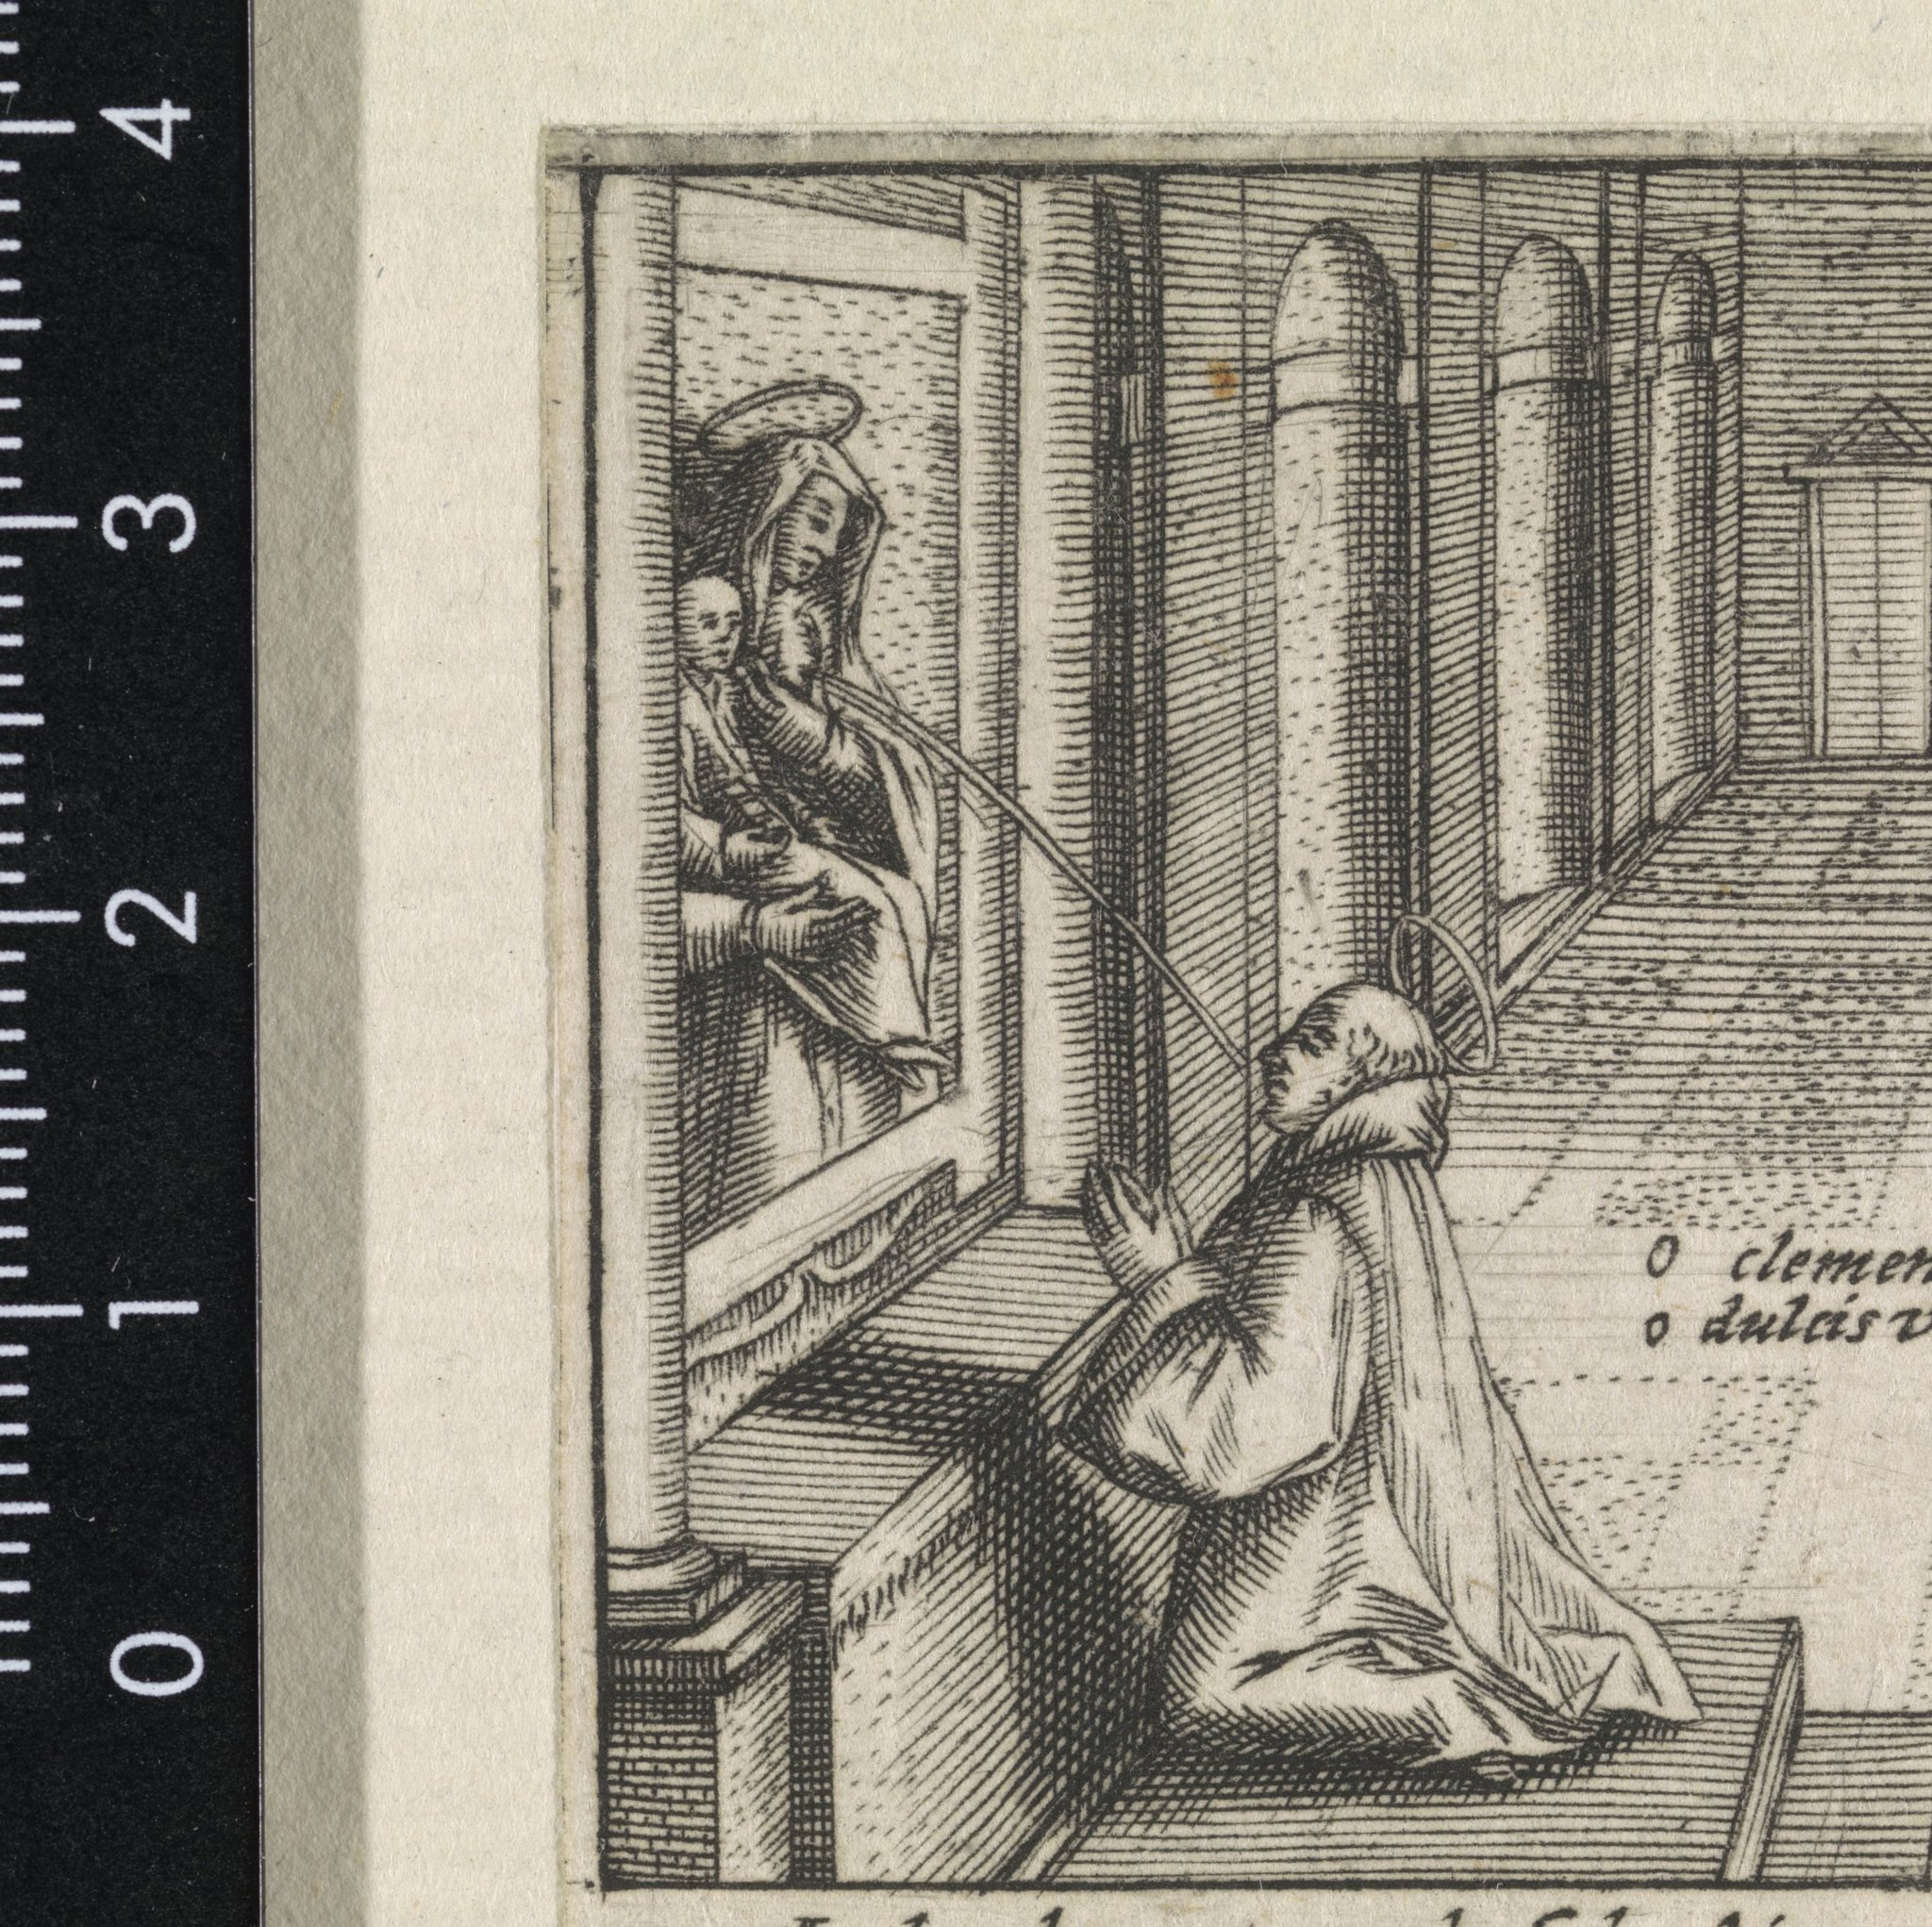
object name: print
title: Heilige Bernardus van Clairvaux ontvangt in een visioen de moedermelk van de maagd Maria (Lactatio Bernardi)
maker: raphaël sadeler (i)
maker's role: print maker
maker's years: 1560-1628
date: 1605-1628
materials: paper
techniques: engraving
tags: st. bernard of clairvaux kneels before the virgin mary who presses her breast from which milk spouts, wetting the lips of bernard ('lactatio')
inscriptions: collector's mark: Lugt 240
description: Tijdens het bidden voor een schilderij van Maria met kind ontvangt de H. Bernardus van Clairvaux in een visioen een druppel moedermelk uit de borst van de maagd Maria. De prent maakt deel uit van een veertiendelige serie die een kader vormt rondom een afbeelding van de H. Bernardus van Clairvaux.